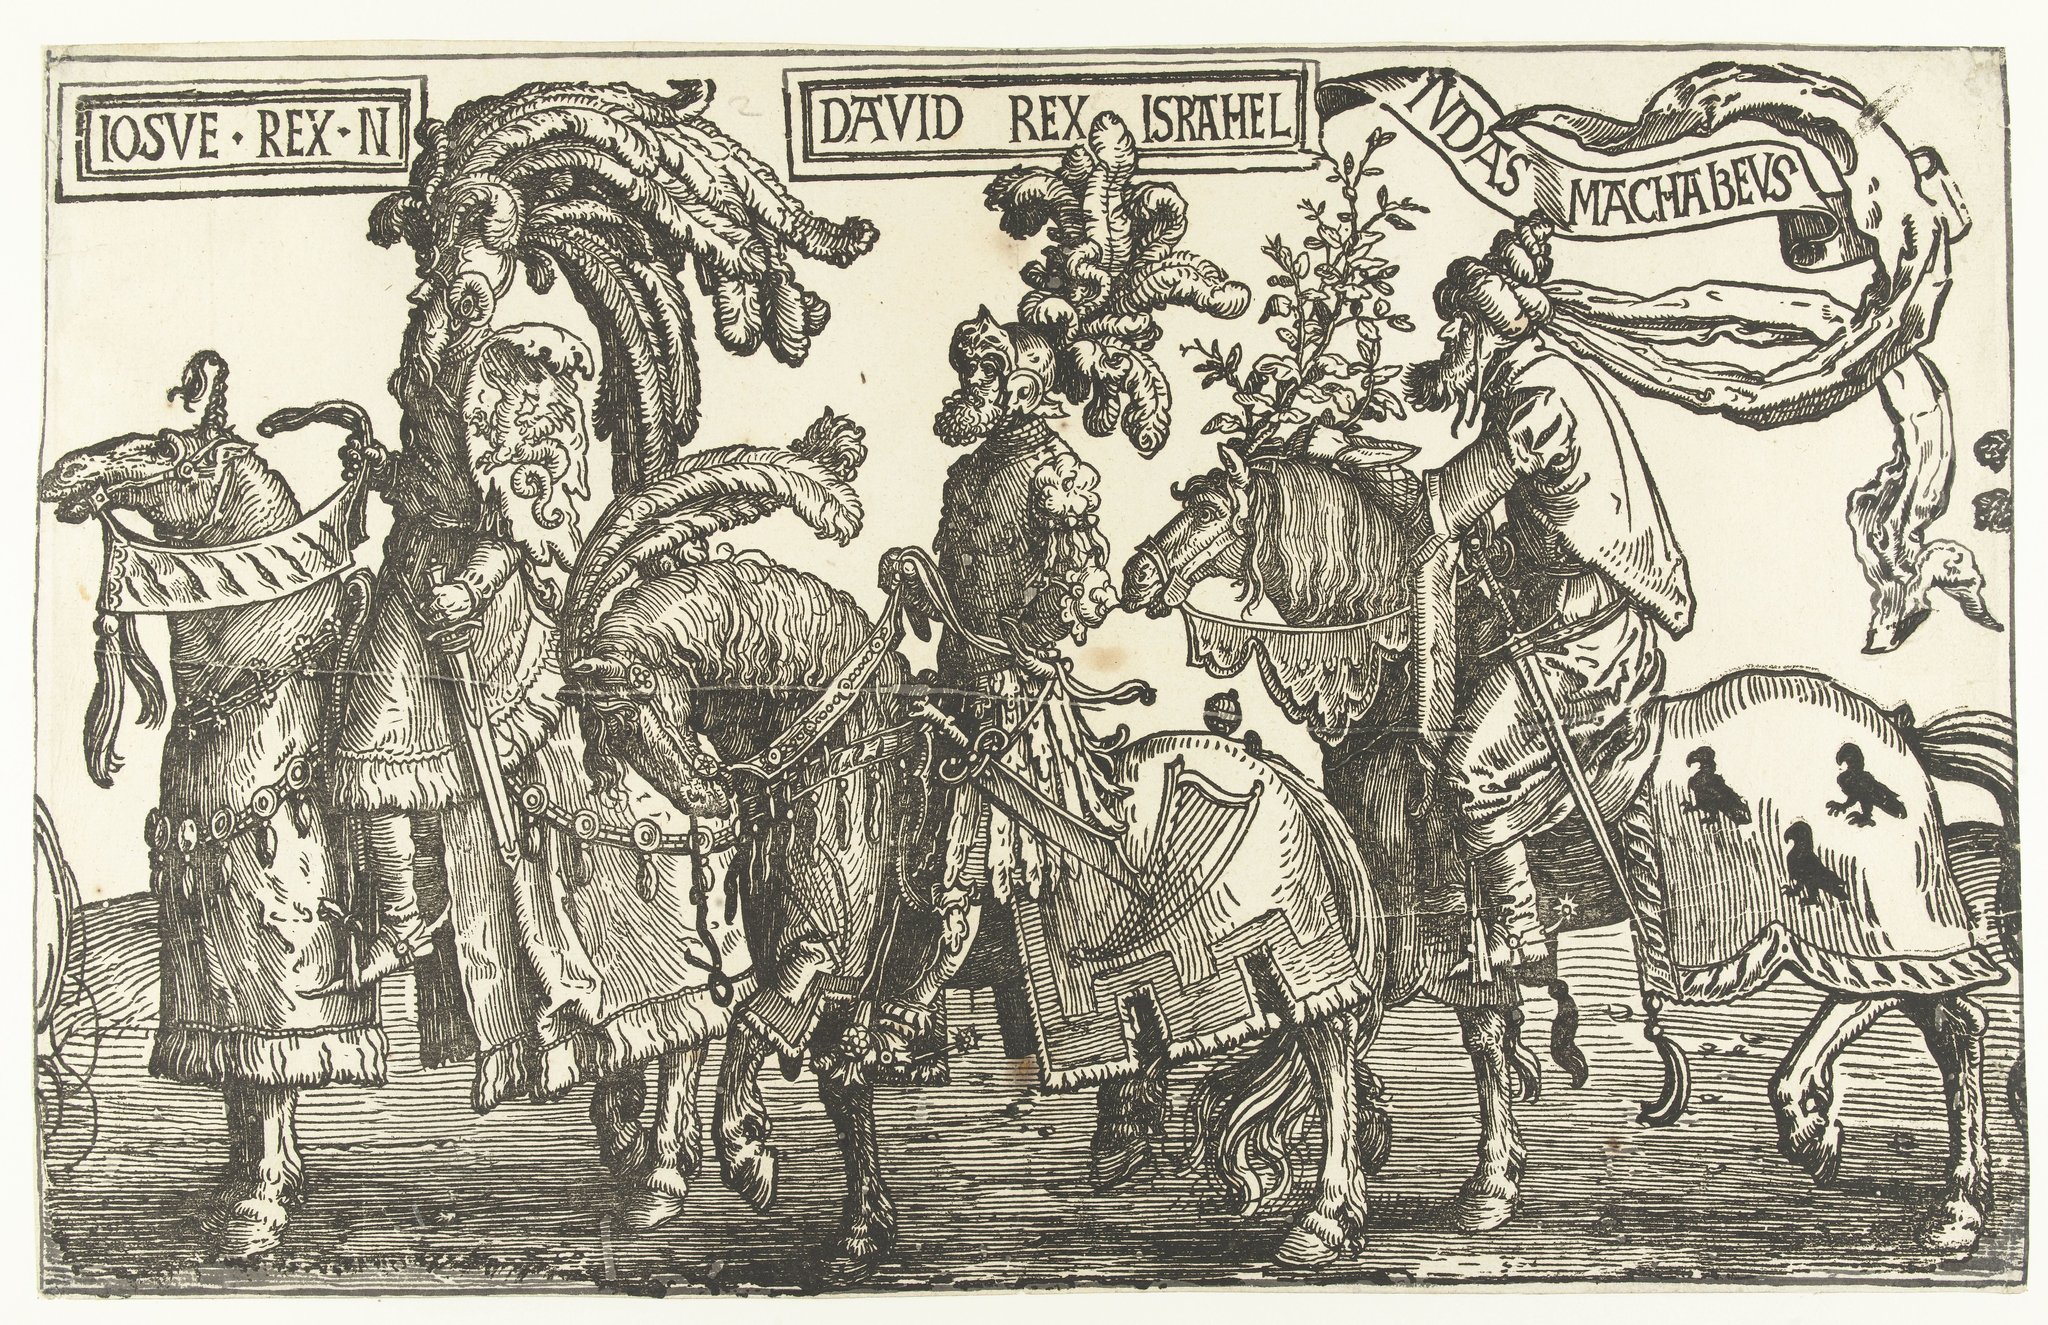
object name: print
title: De negen helden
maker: lucas van leyden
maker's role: draughtsman, painter, print maker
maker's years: 1494-1533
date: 1518-1522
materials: paper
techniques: brush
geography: low countries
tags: judas maccabaeus (one of the nine worthies), david (one of the nine worthies), joshua (one of the nine worthies)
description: Eén van drie houtsneden, onderdeel van fries met negen helden. Drie Joodse helden: koning Jozua, koning David en Judas de Makkabeeër te paard. Boven alle drie een kader met naam en toenaam.